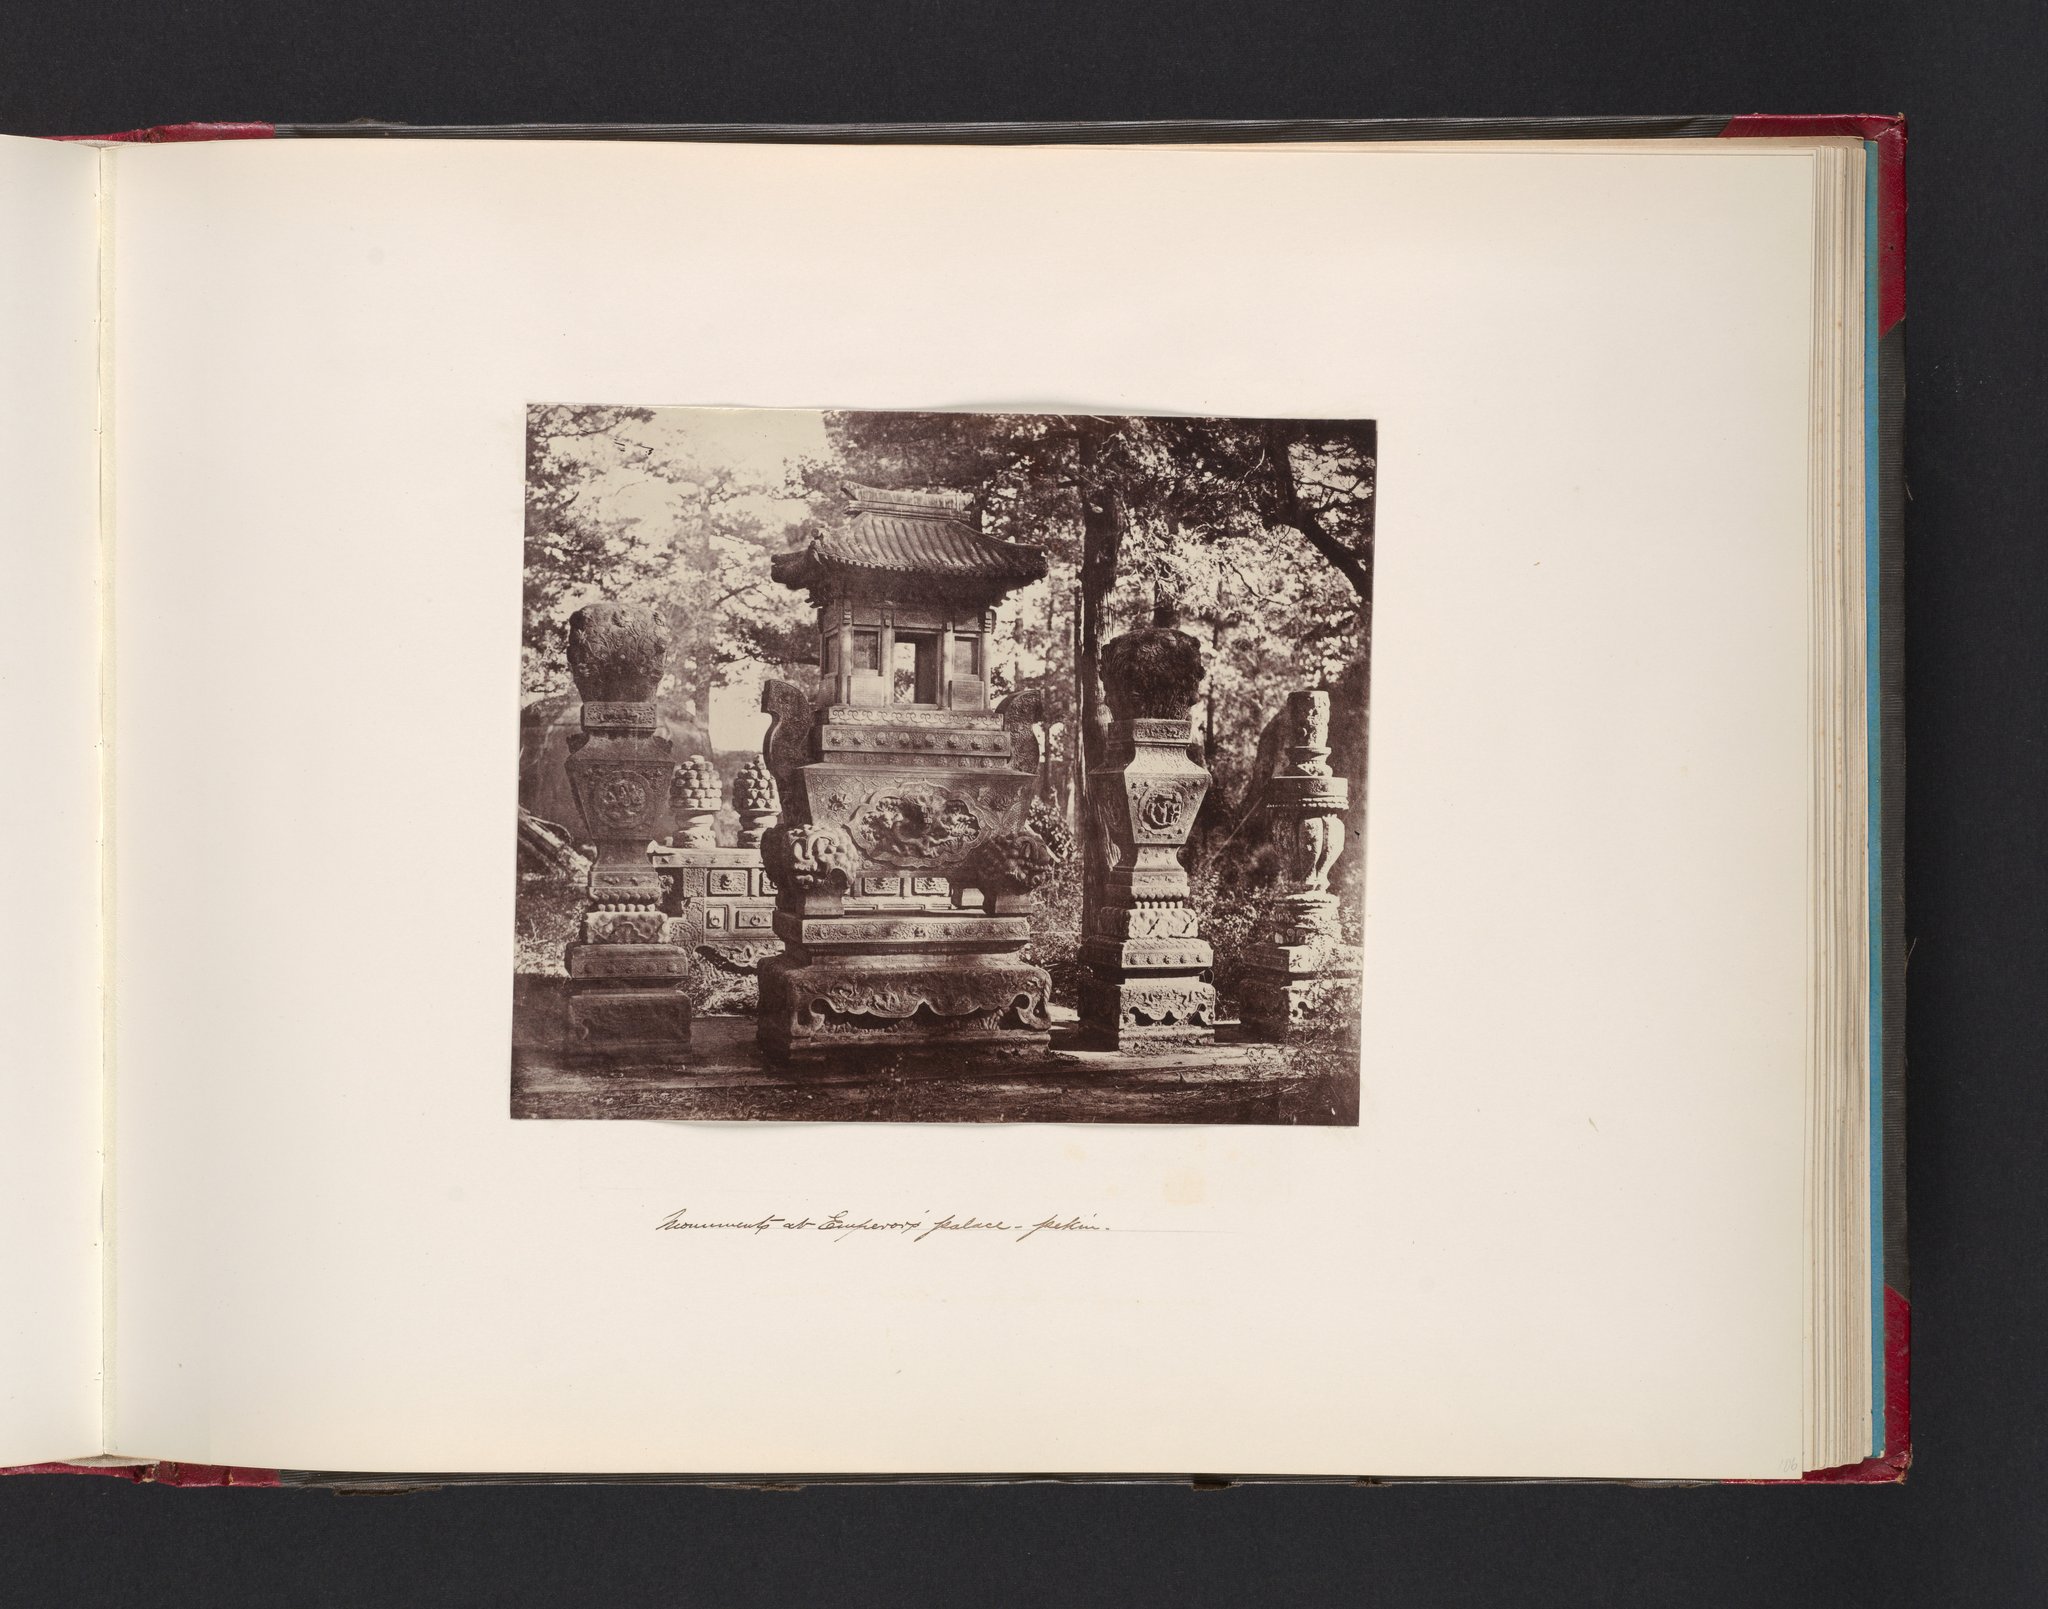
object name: photograph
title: Monuments at Emperor Palace, Pekin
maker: john thomson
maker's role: artist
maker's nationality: british, scottish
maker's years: 1837-1921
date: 1865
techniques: albumen silver print, glass negative